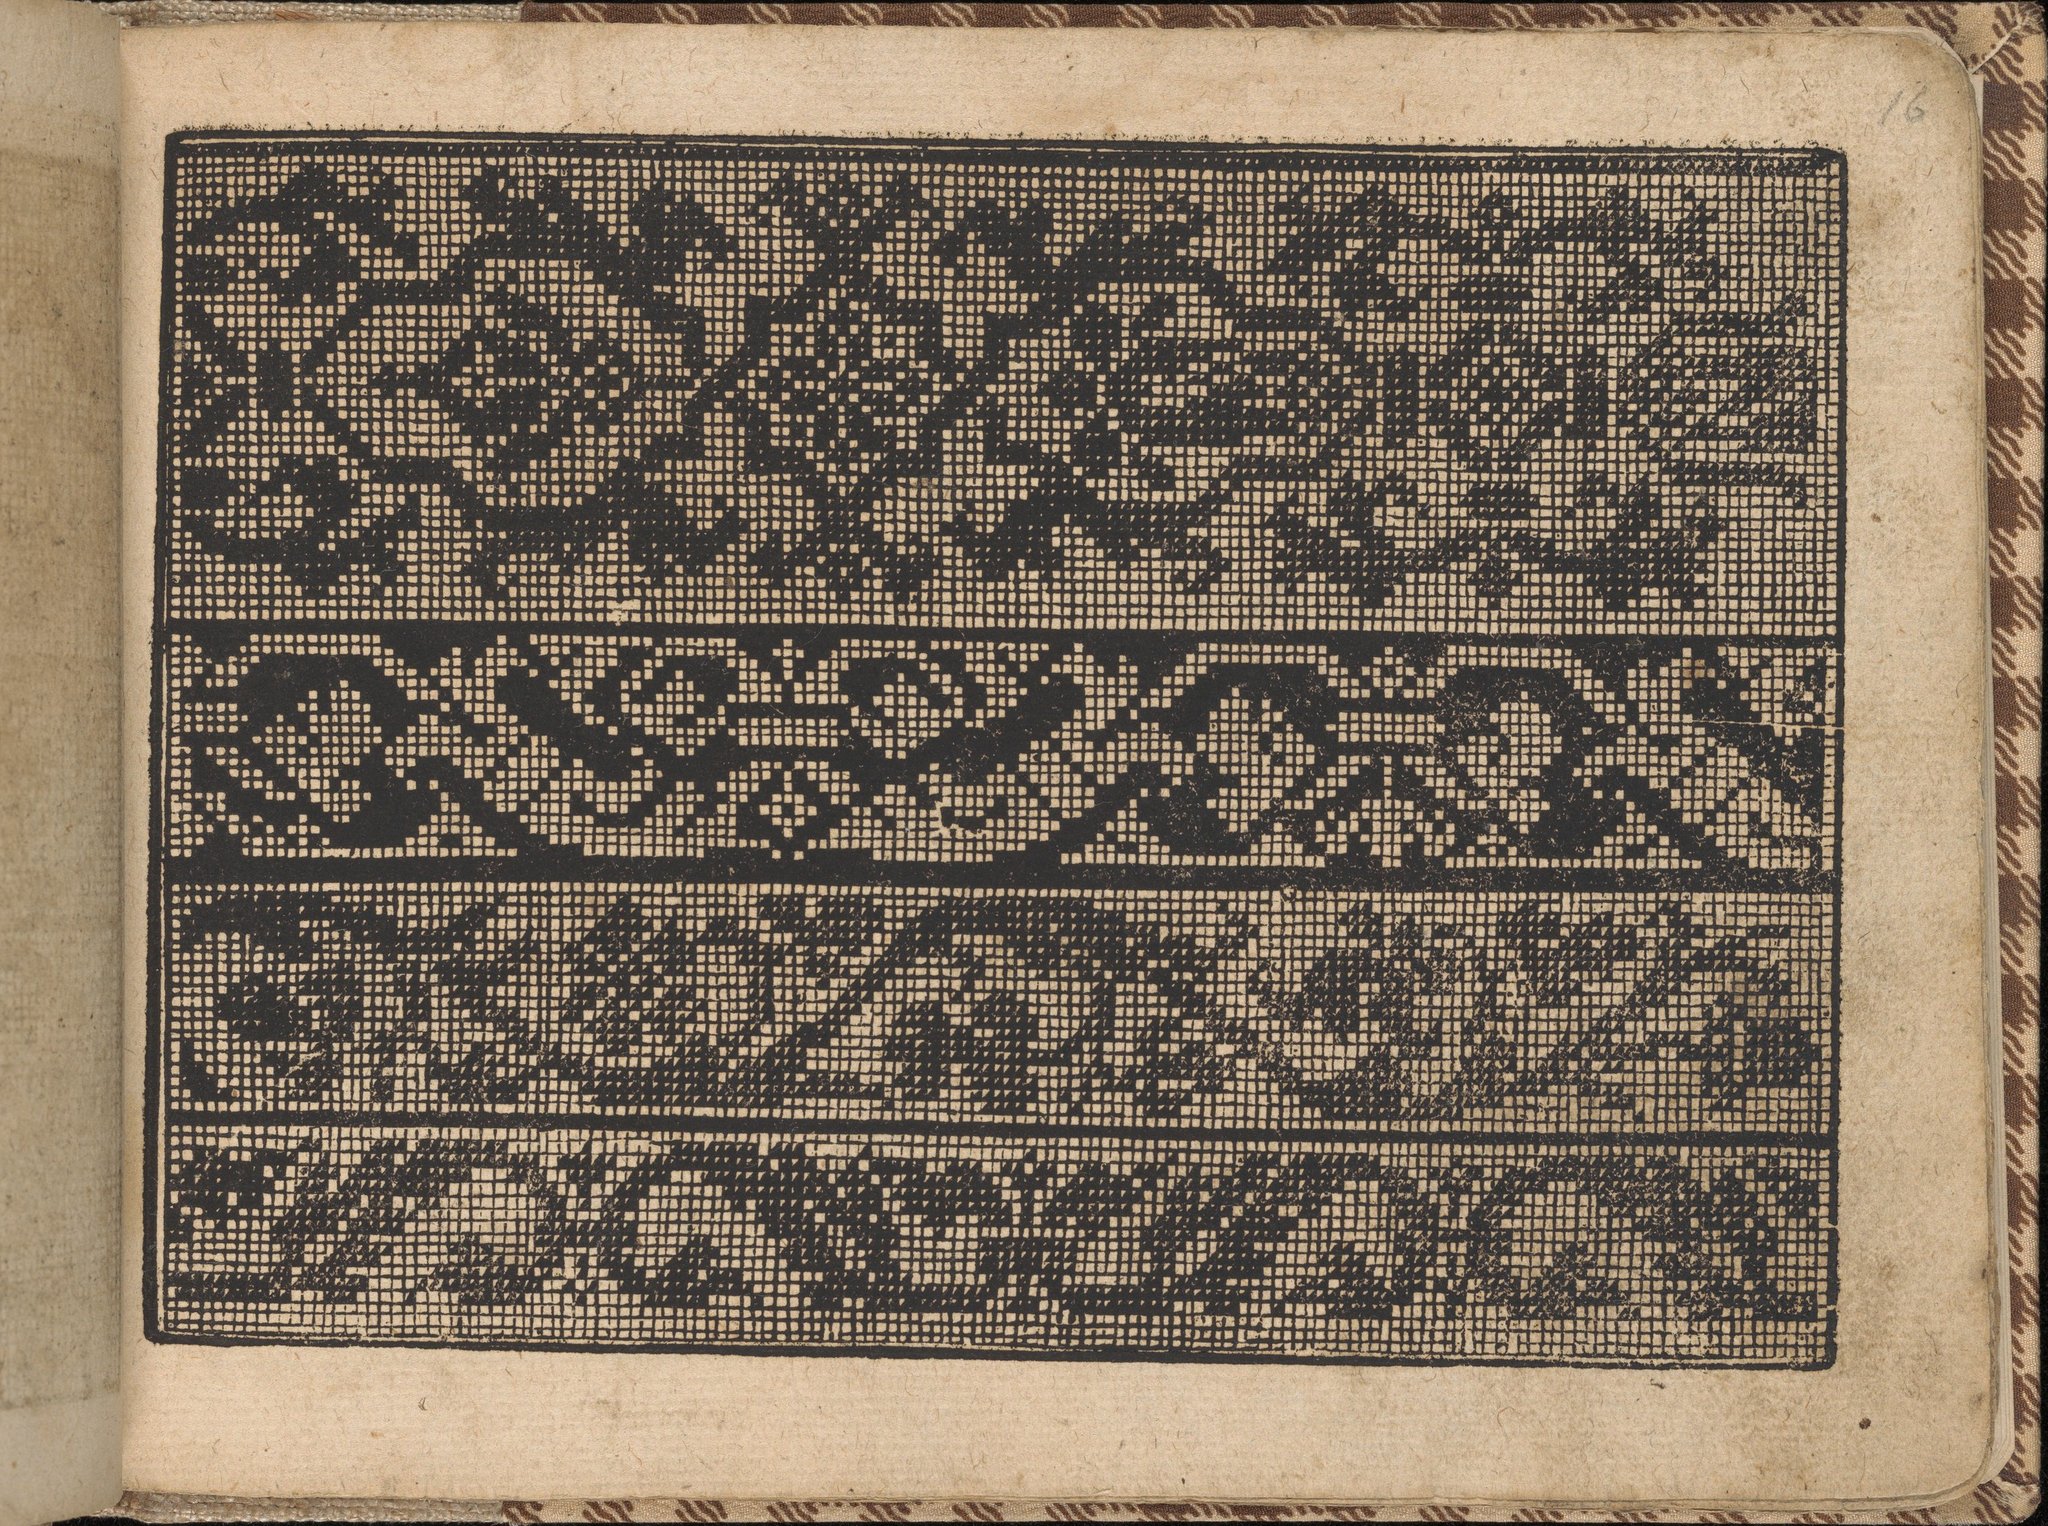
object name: book print ornament architecture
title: New Künstlichs Modelbuch (Page 16 recto)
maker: bernhard jobin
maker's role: publisher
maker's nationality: swiss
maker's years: 1535-1597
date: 1600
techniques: woodcut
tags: ornament